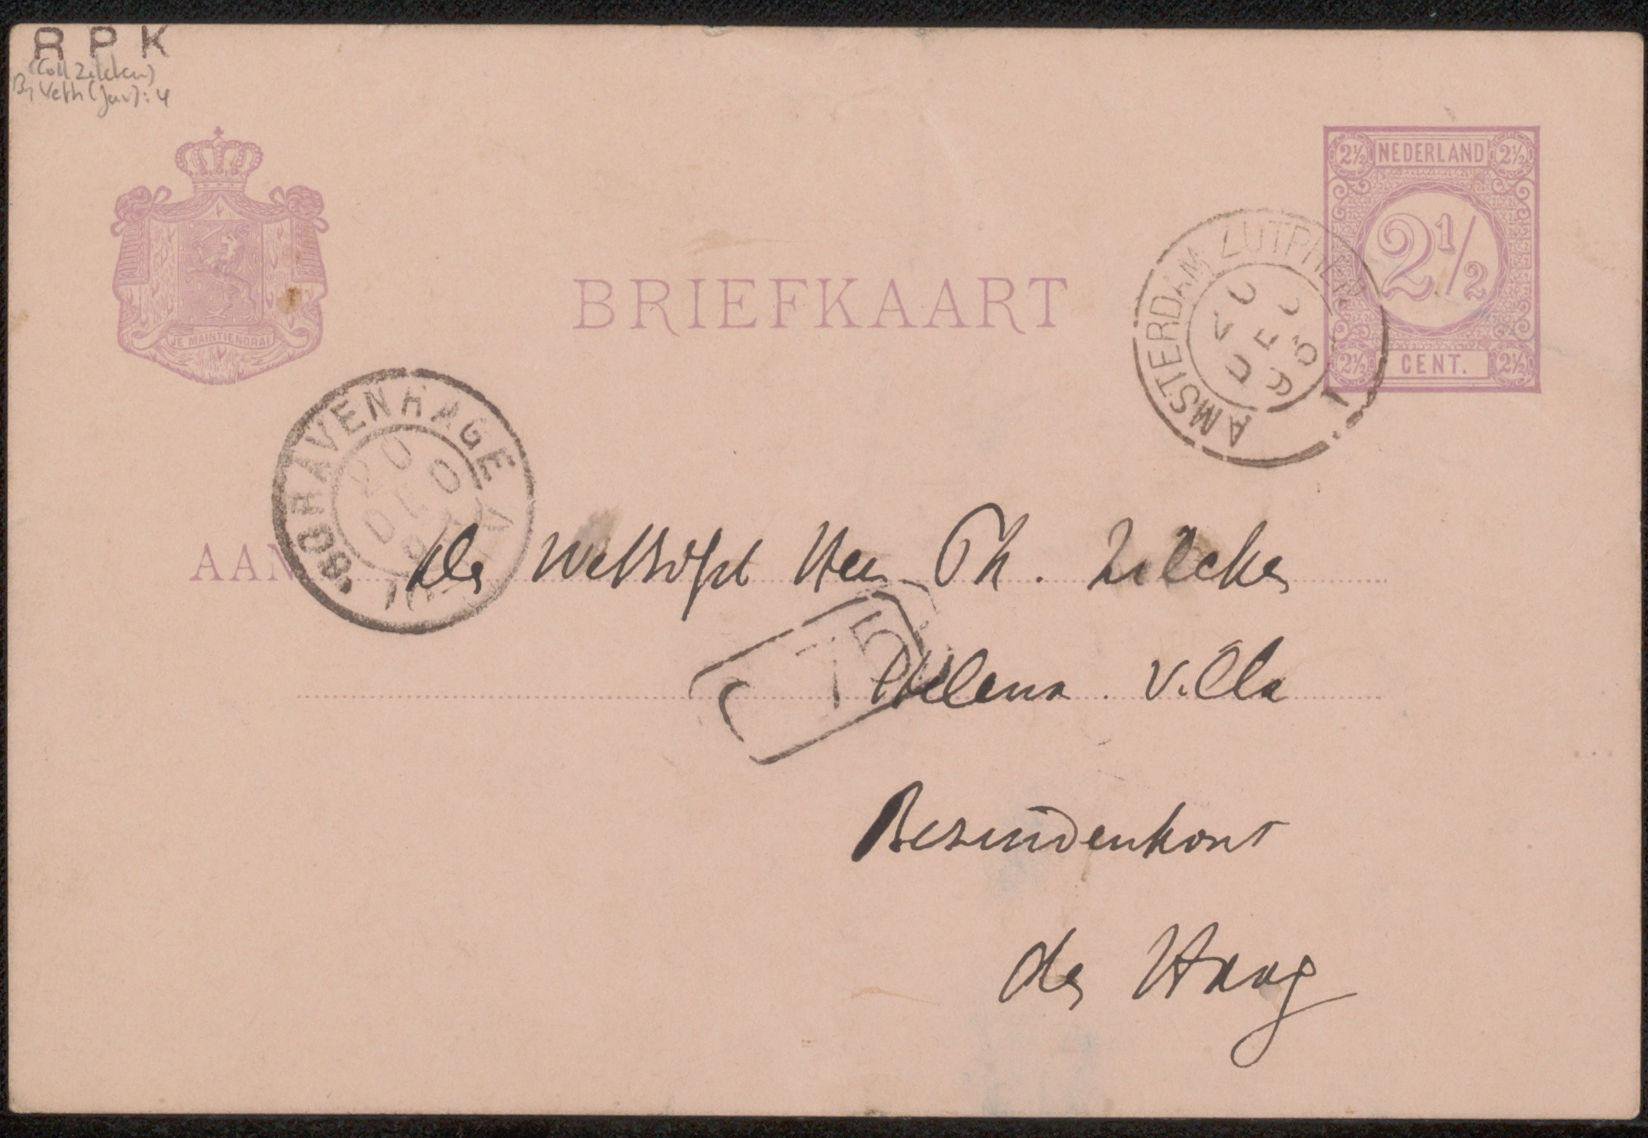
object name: postcard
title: Briefkaart aan Philip Zilcken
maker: jan veth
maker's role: designer, draughtsman, painter, print maker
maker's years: 1864-1925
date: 1893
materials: cardboard, ink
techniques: pen, writing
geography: bussum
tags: the hague, philip zilcken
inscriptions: collector's mark: ‘RPK’